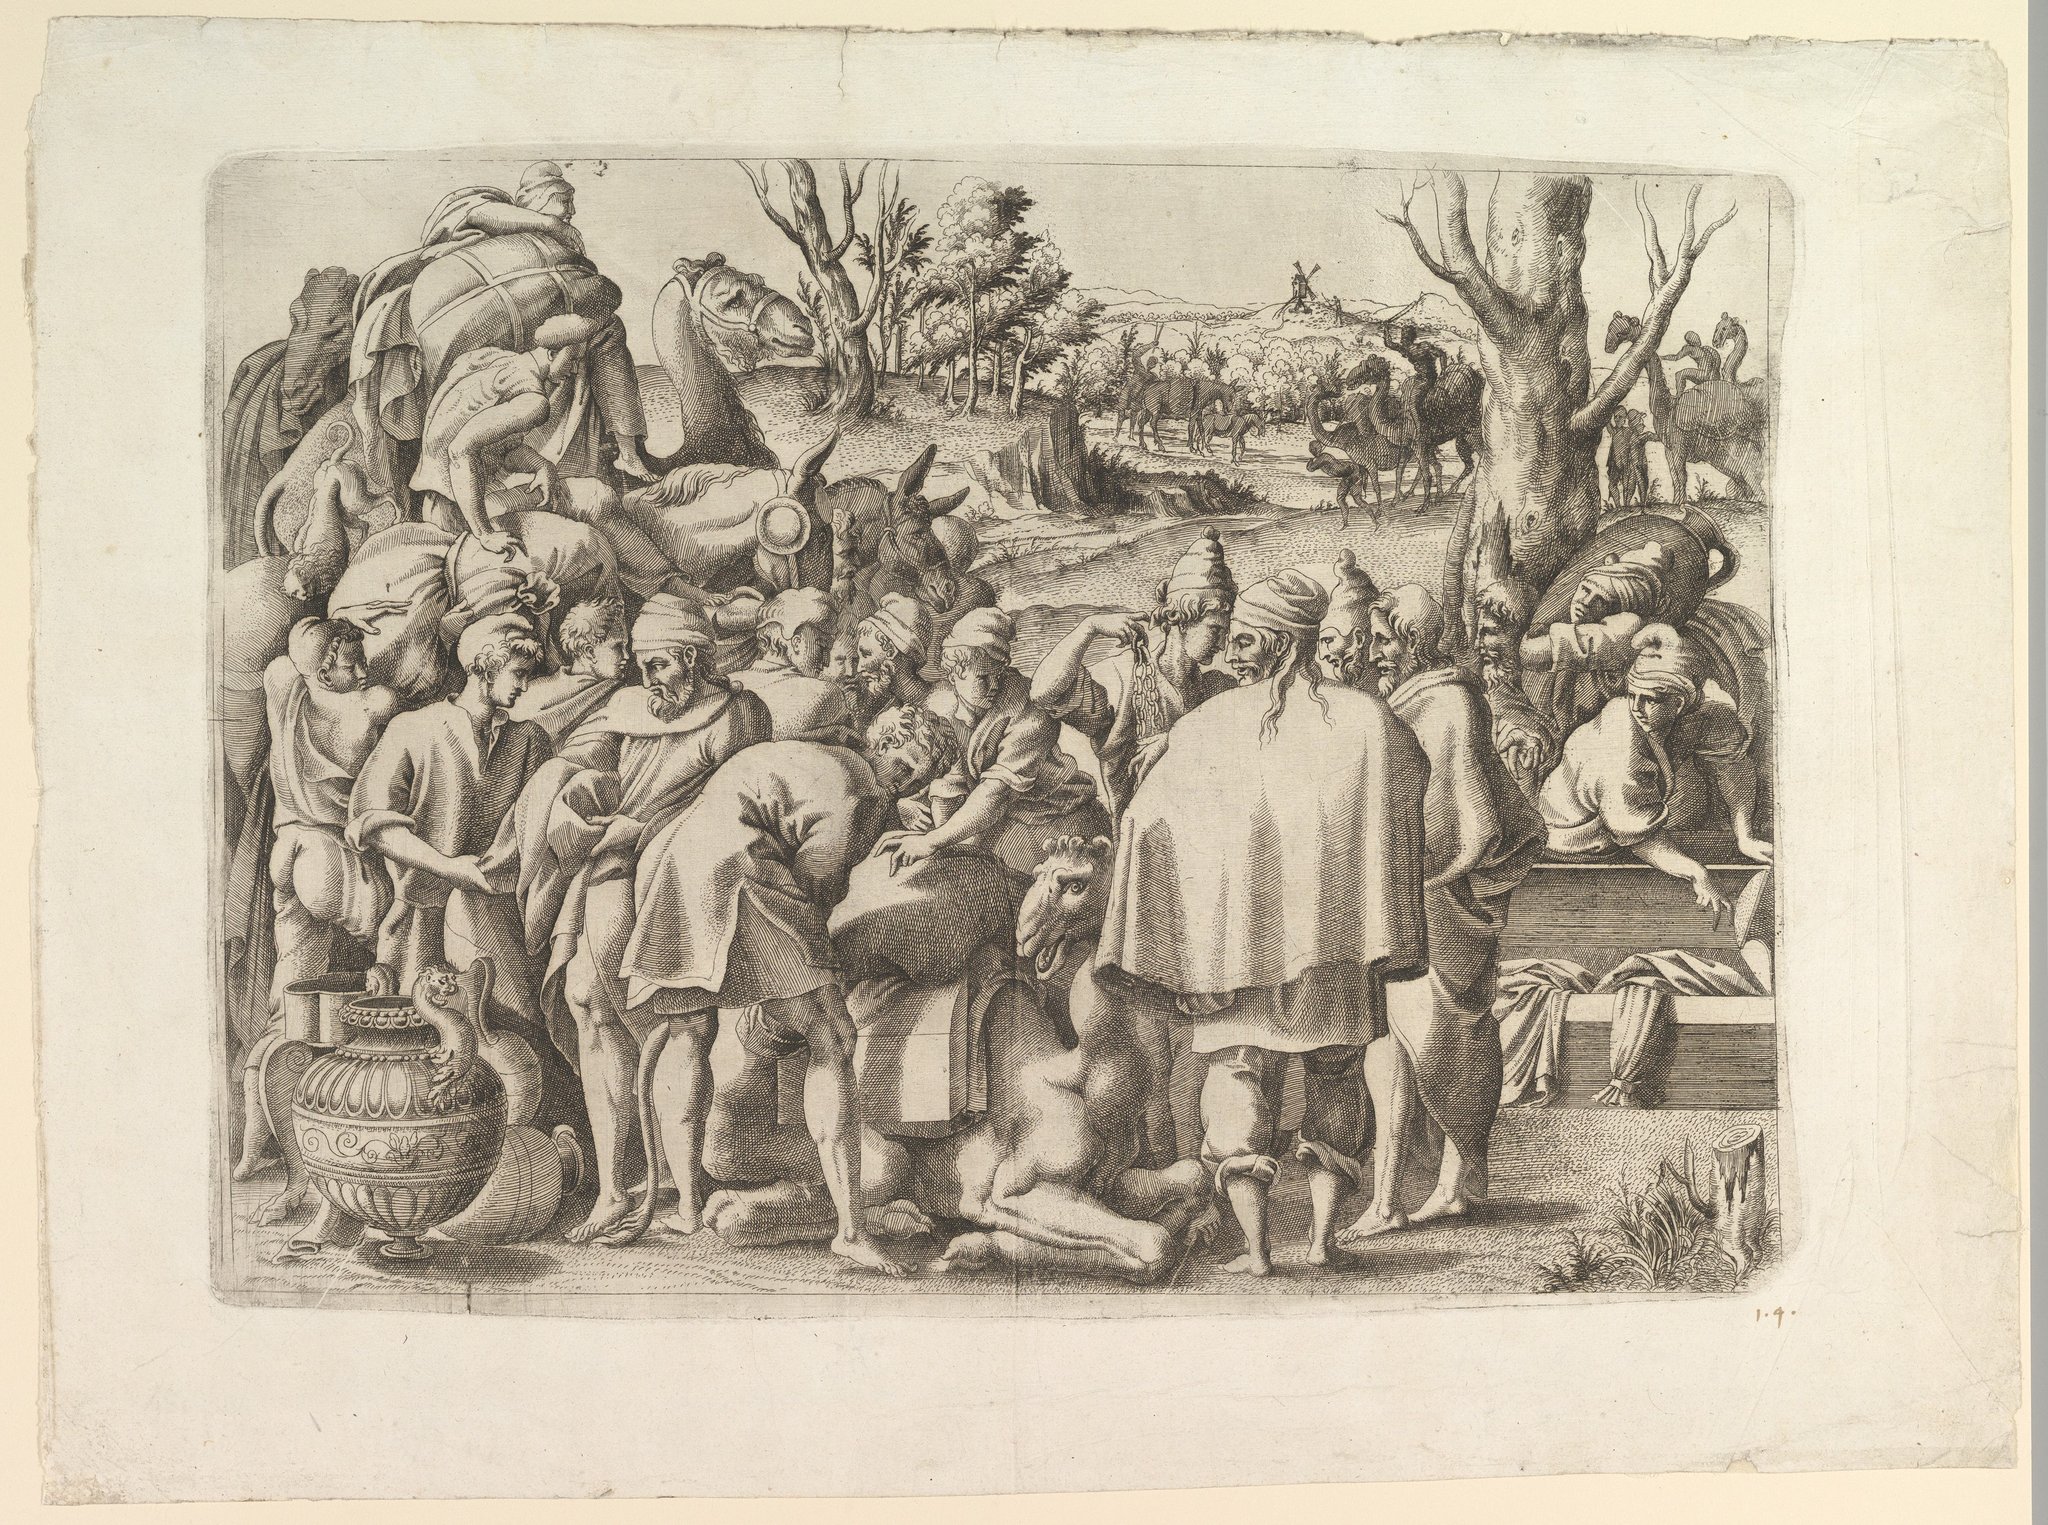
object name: print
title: Search through the Luggage of Joseph's Brother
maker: anonymous, french, school of fontainebleau, 16th century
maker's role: artist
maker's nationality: french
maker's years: 1500-1600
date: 1545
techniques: etching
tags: men,camels,trees